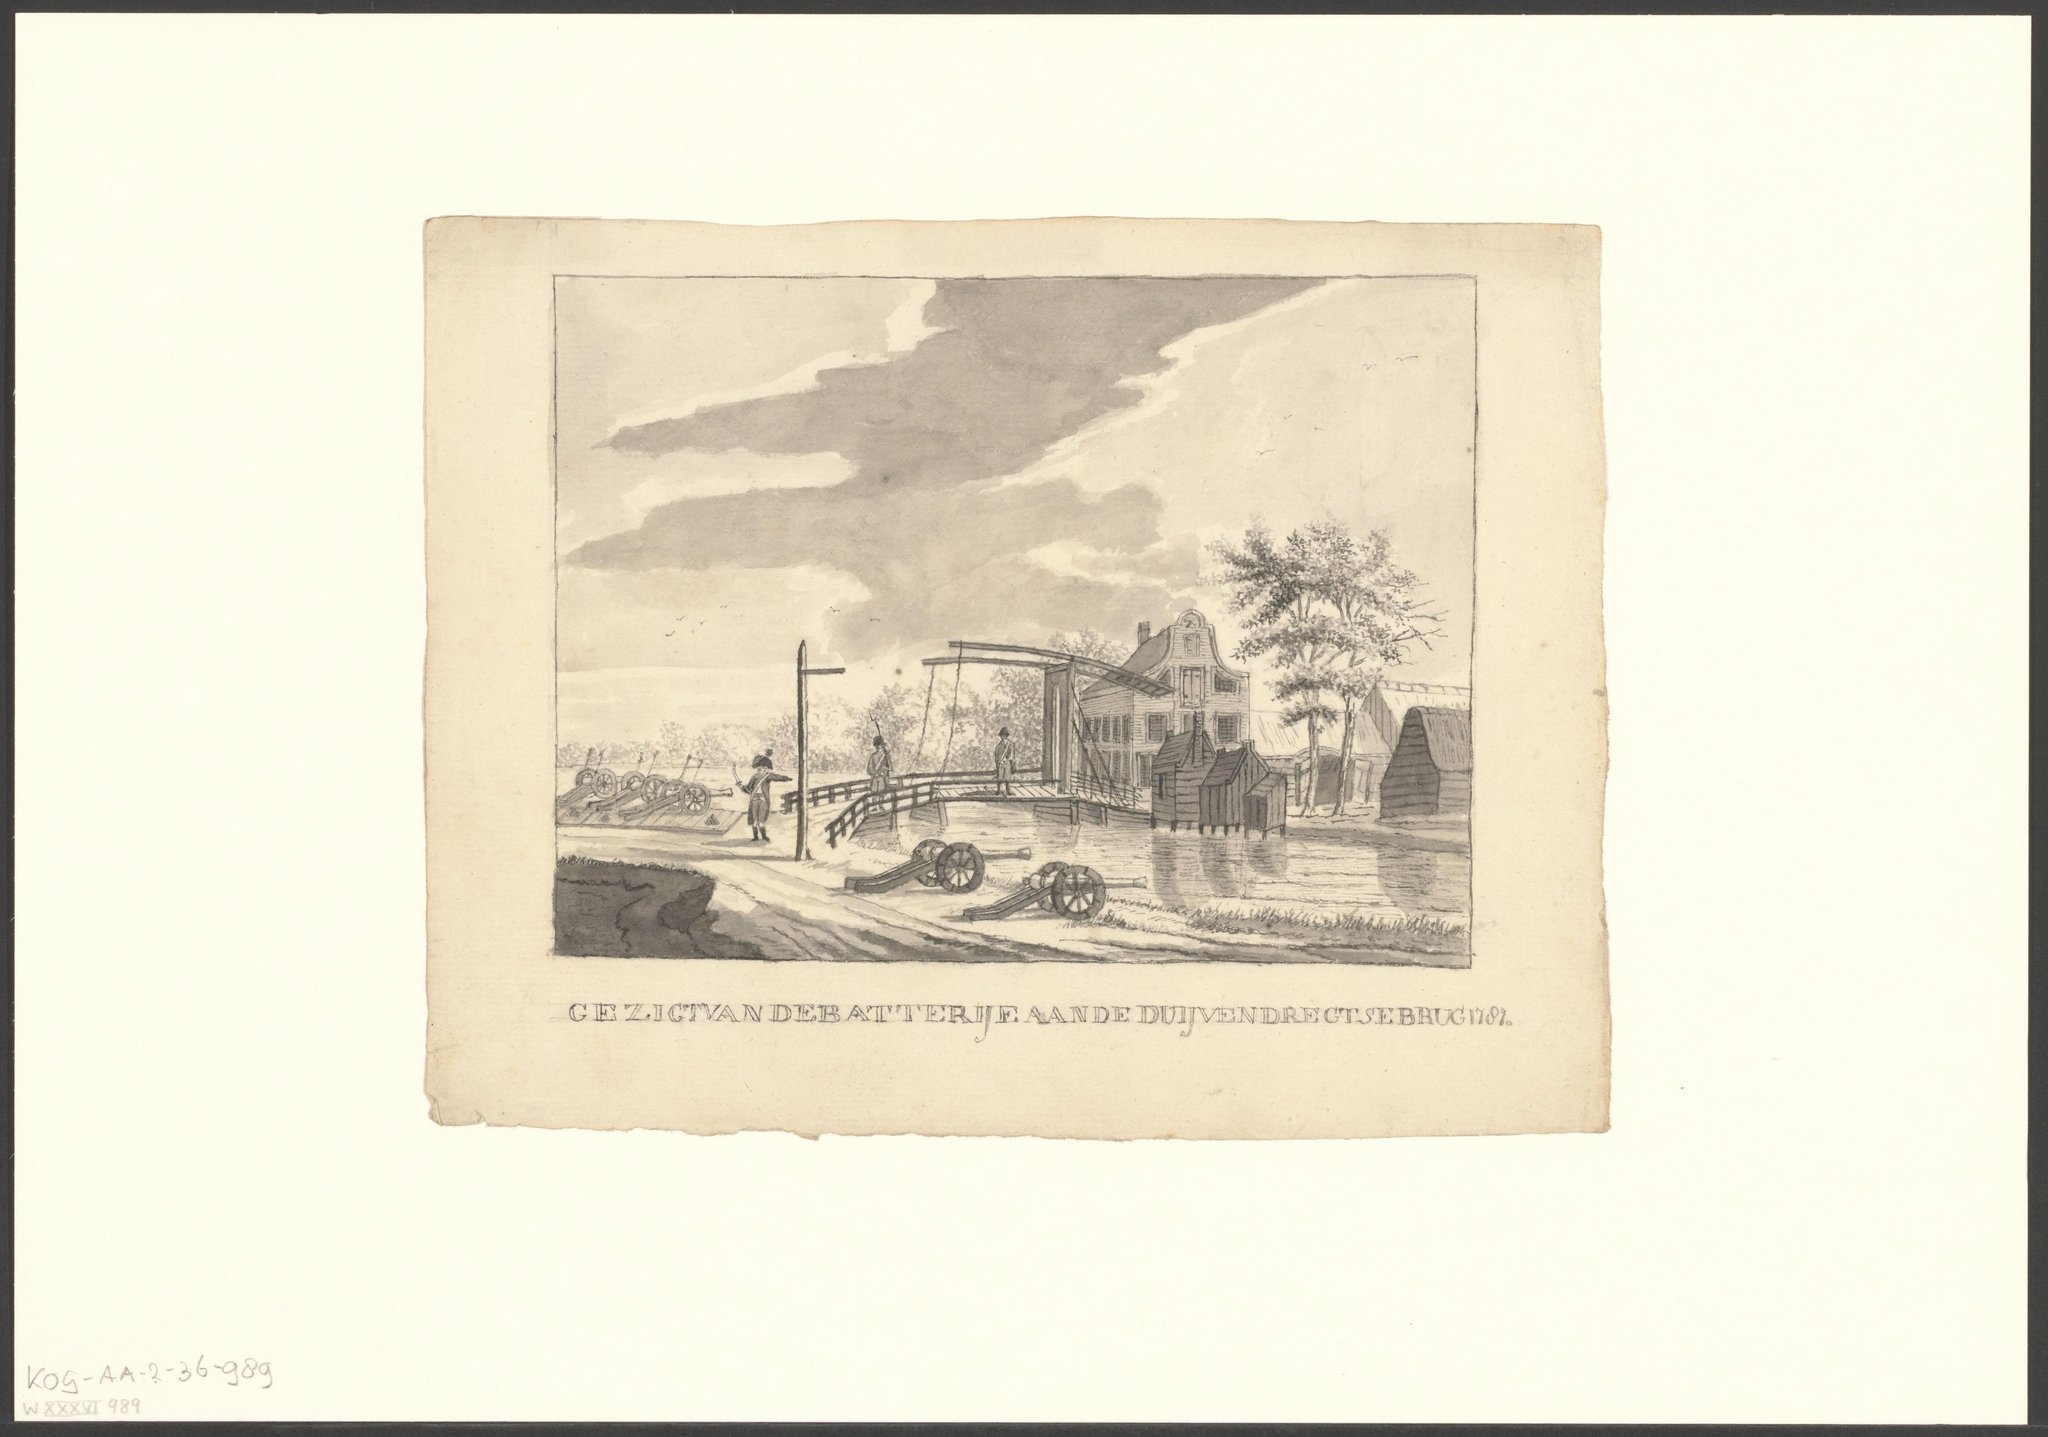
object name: drawing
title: Gezigt van de batterije aan de Duijvendregtse Brug 1787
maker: Anonymous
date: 1787-1899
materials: ink, paper, pencil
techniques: brush, pen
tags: defence of fortification or city, defensive measures (military)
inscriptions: inscription: ‘Gezigt van de batterije aan de Duijvendregtse Brug 1787.’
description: Tekening binnen de Atlas Van Eck ingedeeld op wijknummer 36.